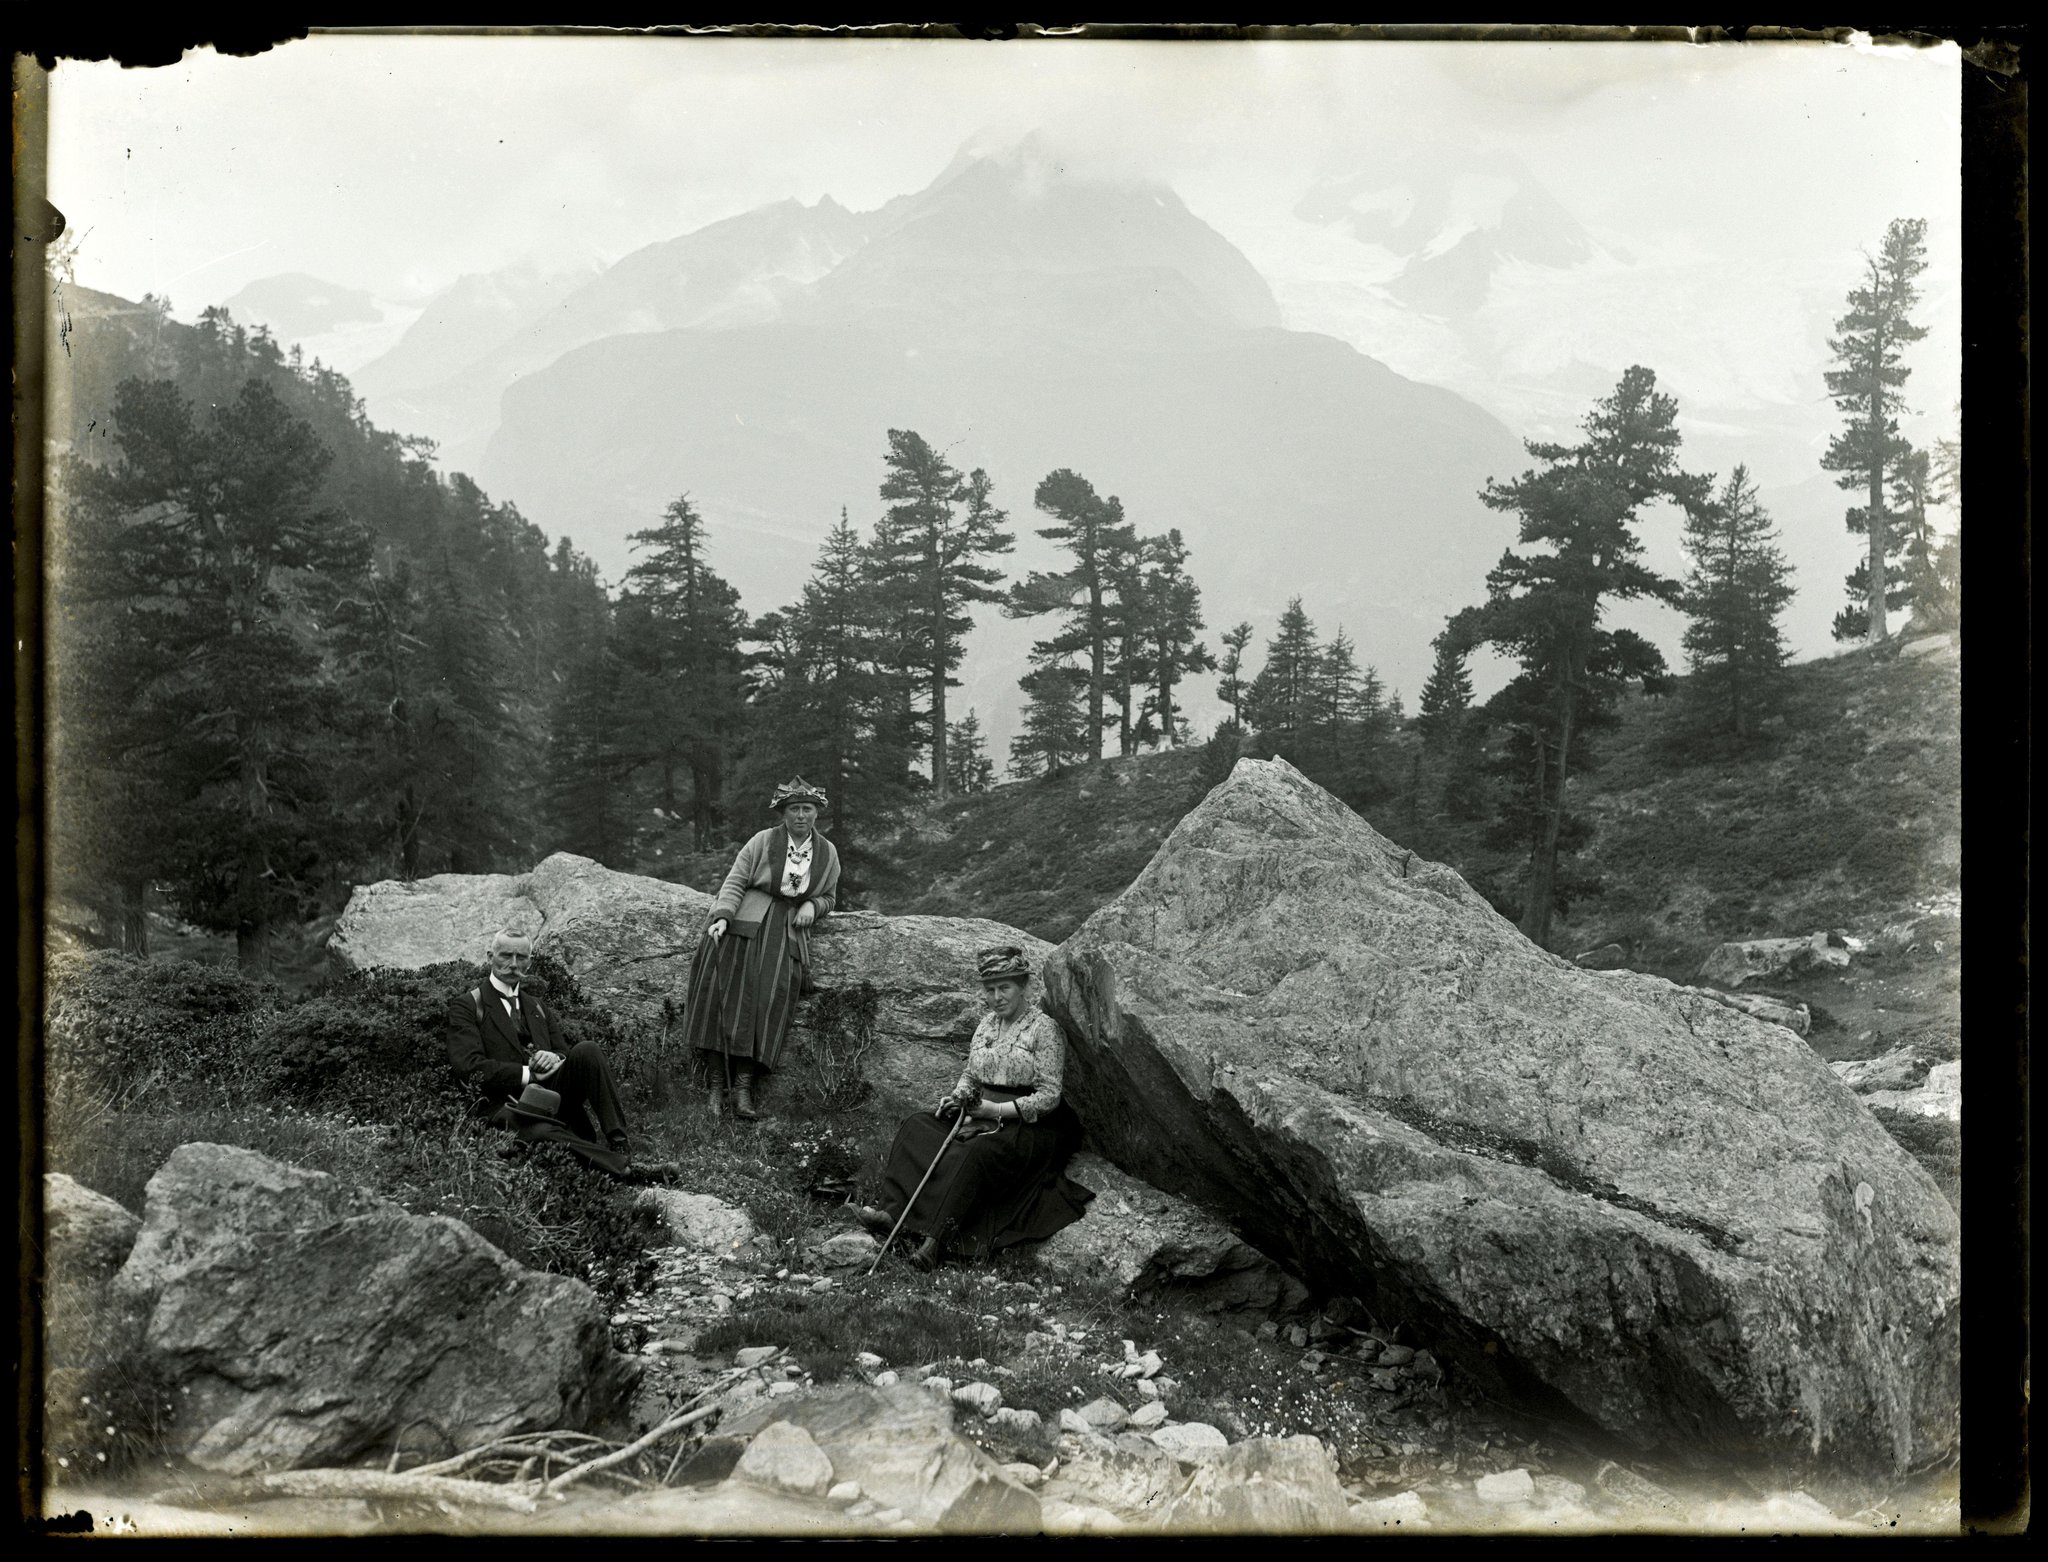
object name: glasnegatief, glasplaatnegatief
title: Portret van een onbekende man en twee onbekende vrouwen in berglandschap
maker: Anonymous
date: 1907-1935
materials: glass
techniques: gelatin glass negative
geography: europe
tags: historical persons not known by name, mountains, europe